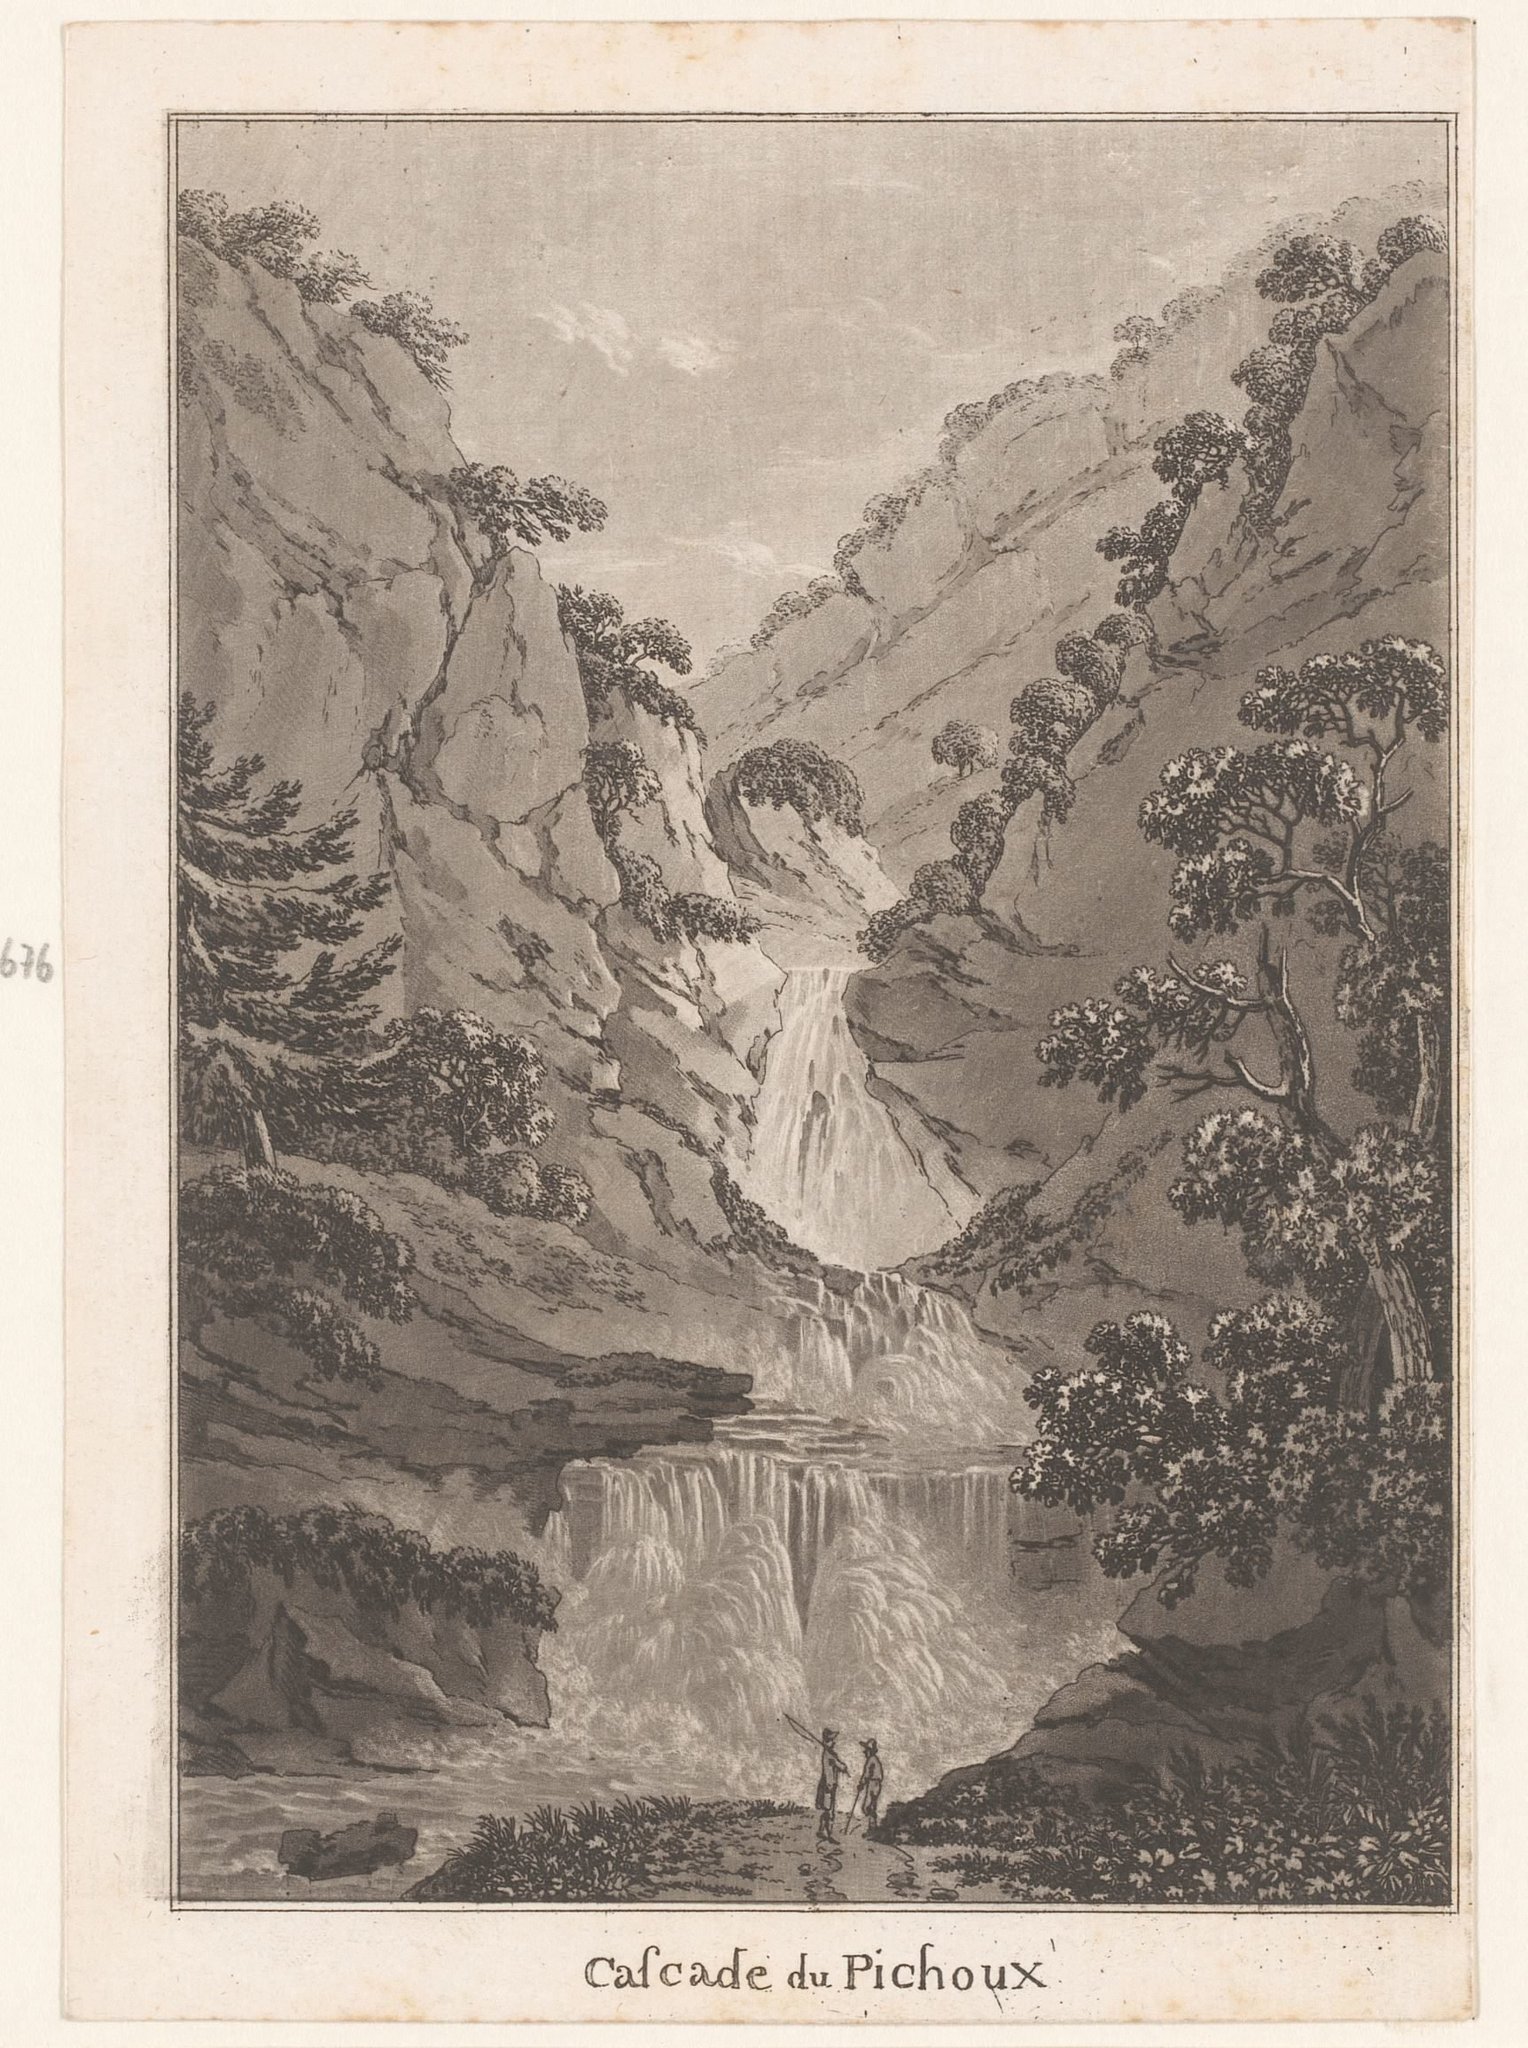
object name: print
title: Gezicht op de waterval van Pichoux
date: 1810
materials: paper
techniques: aquatint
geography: amsterdam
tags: waterfall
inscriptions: collector's mark: Lugt 2228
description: Prent ook gebruikt in: Promenade Pittoresque dans l'évêché de bâle aux bords de la Birs (...). Amsterdam: T.B. Groebe, 1710.